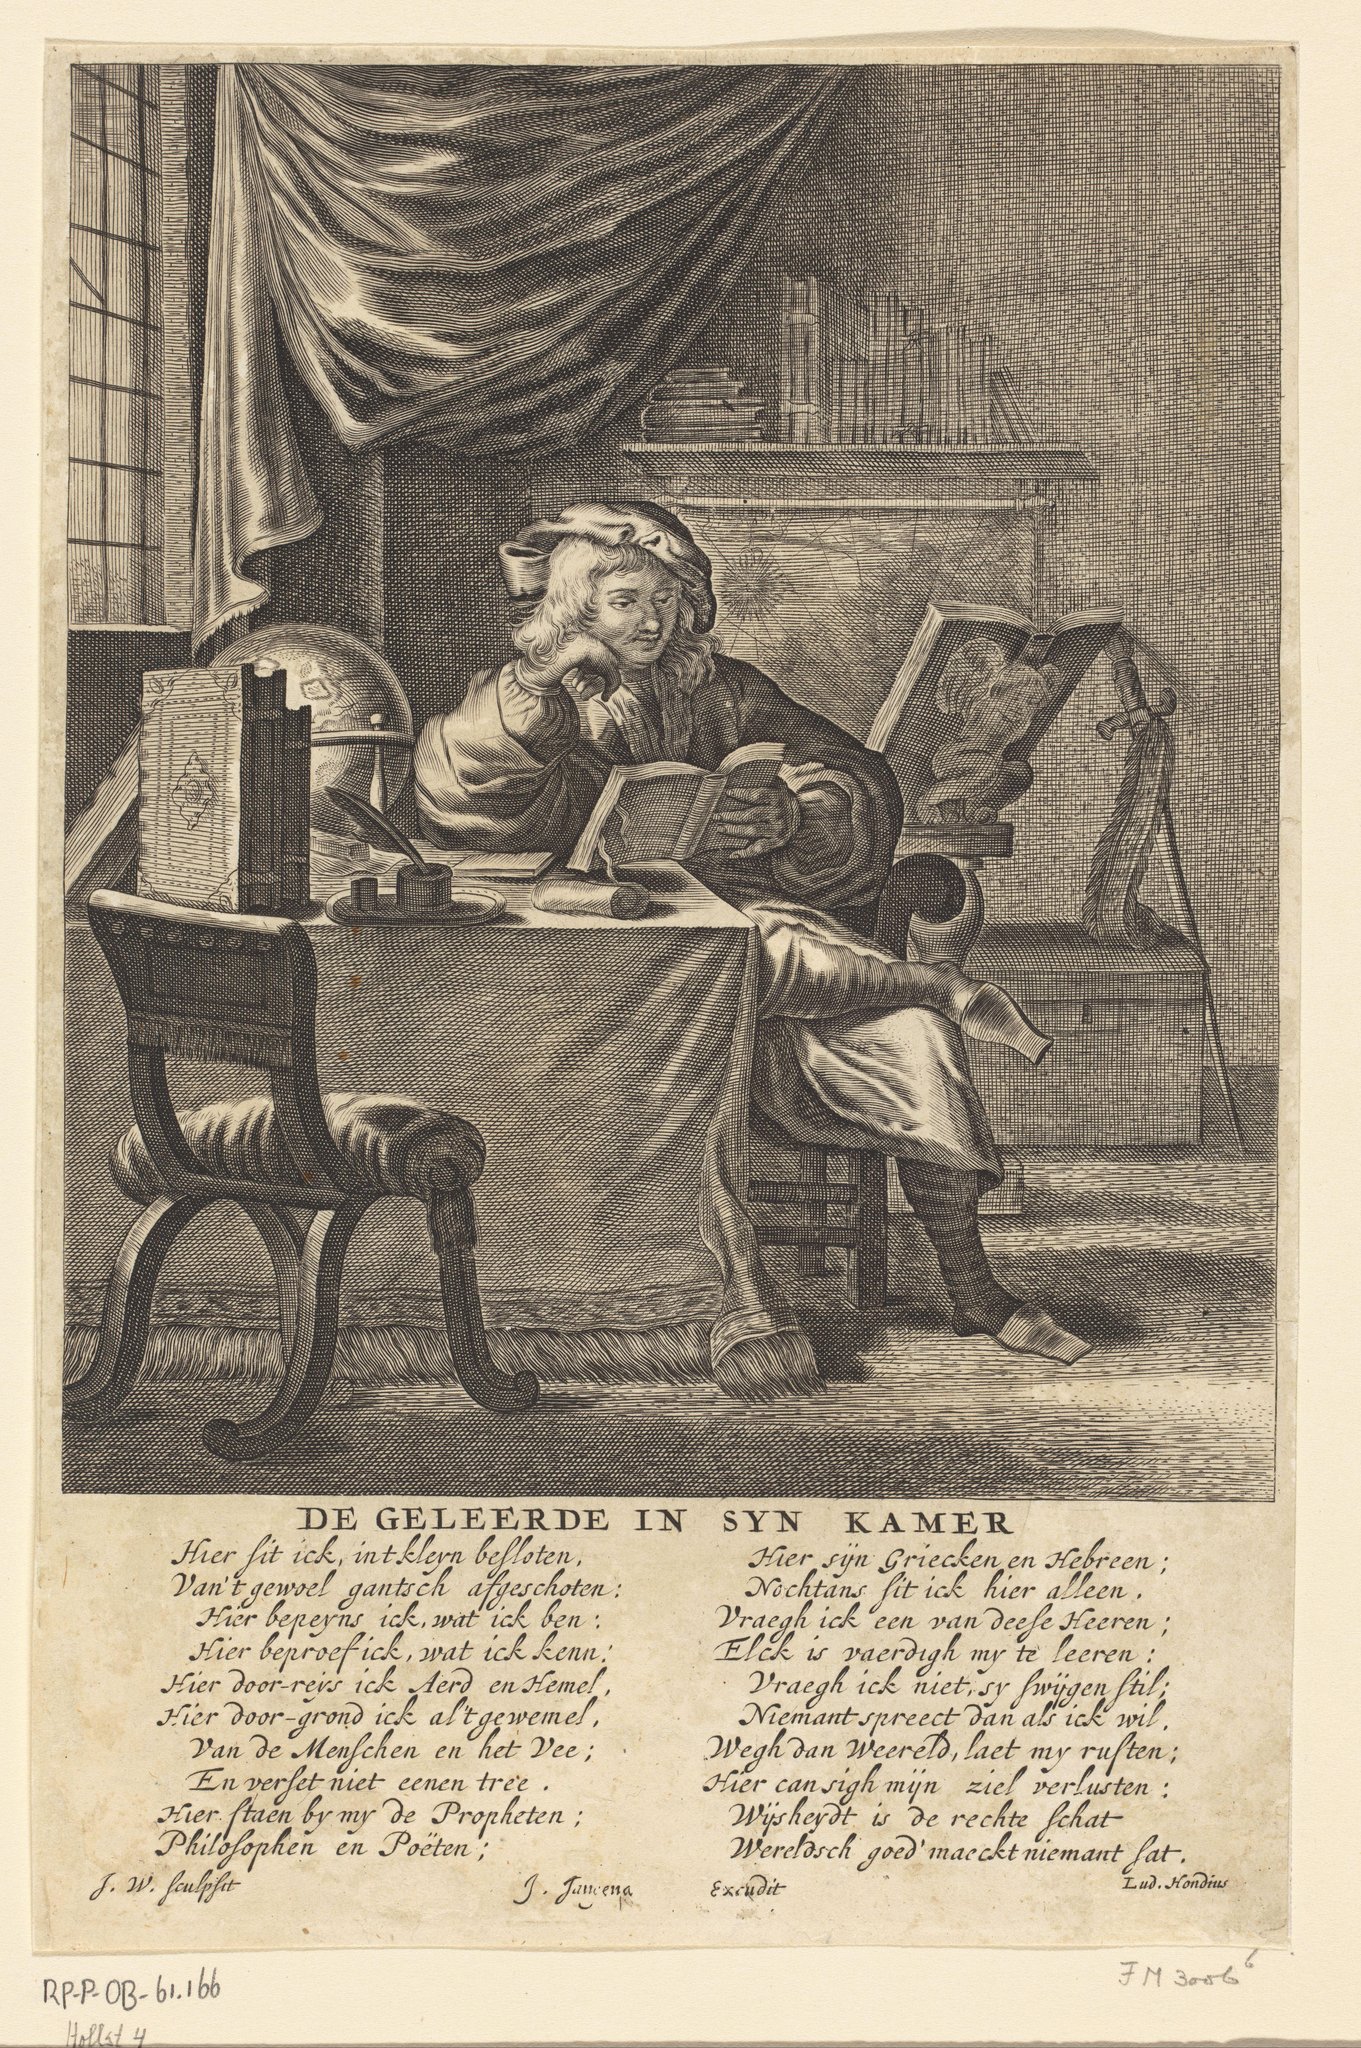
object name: print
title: De geleerde in syn kamer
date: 1686-1693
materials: paper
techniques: engraving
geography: amsterdam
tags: scholar in his study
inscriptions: collector's mark: Lugt 2228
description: Een man leest een boek in zijn studeerkamer. Zijn gedachten zijn weergeven in een vers door Ludovicus Hondius. In de marge het twintigregelig vers, in twee kolommen, in het Nederlands.